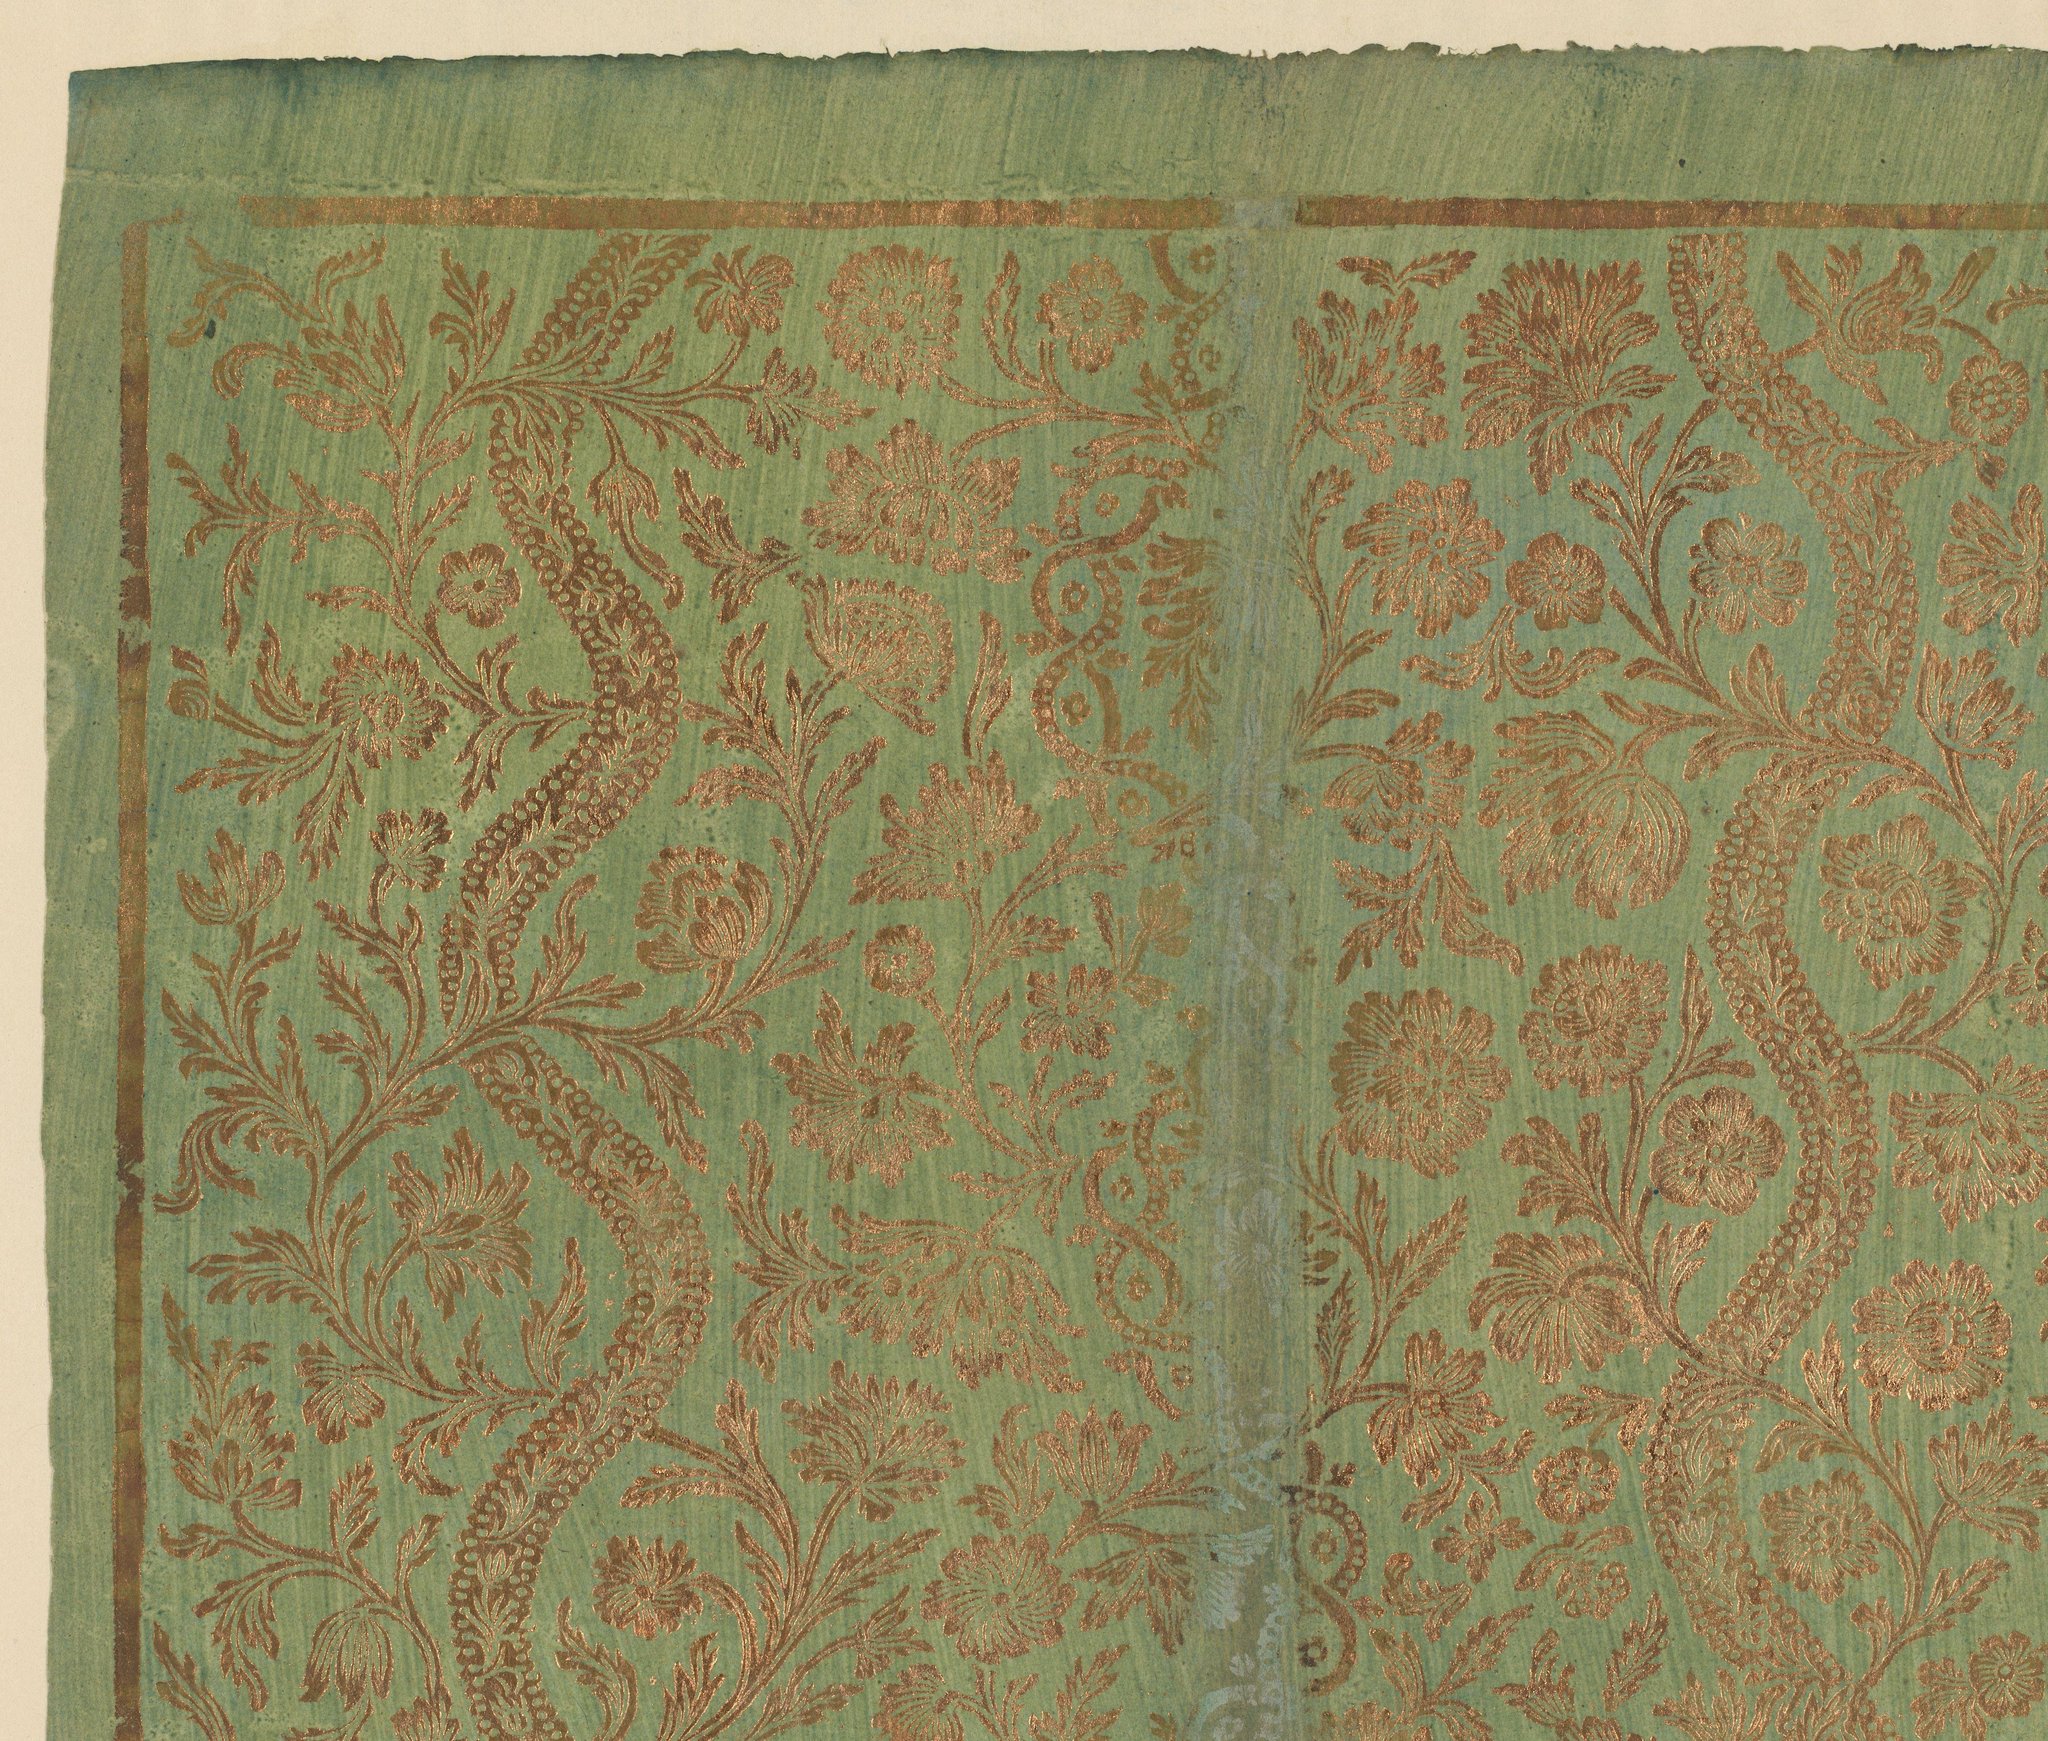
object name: brocade paper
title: Blad met twee slingerende banen tussen ranken met bloemen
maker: paul reimund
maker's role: sierpapiermaker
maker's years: 1764-1815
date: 1783-1815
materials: gold leaf, paint, paper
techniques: relief print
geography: nuremberg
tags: ornament derived from plant forms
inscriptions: collector's mark: Lugt 2760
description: Blad met twee slingerende kantachtige banen tussen ranken met bloemen. Rechtsonder genummerd No. 8 of 18 [slecht leesbaar].